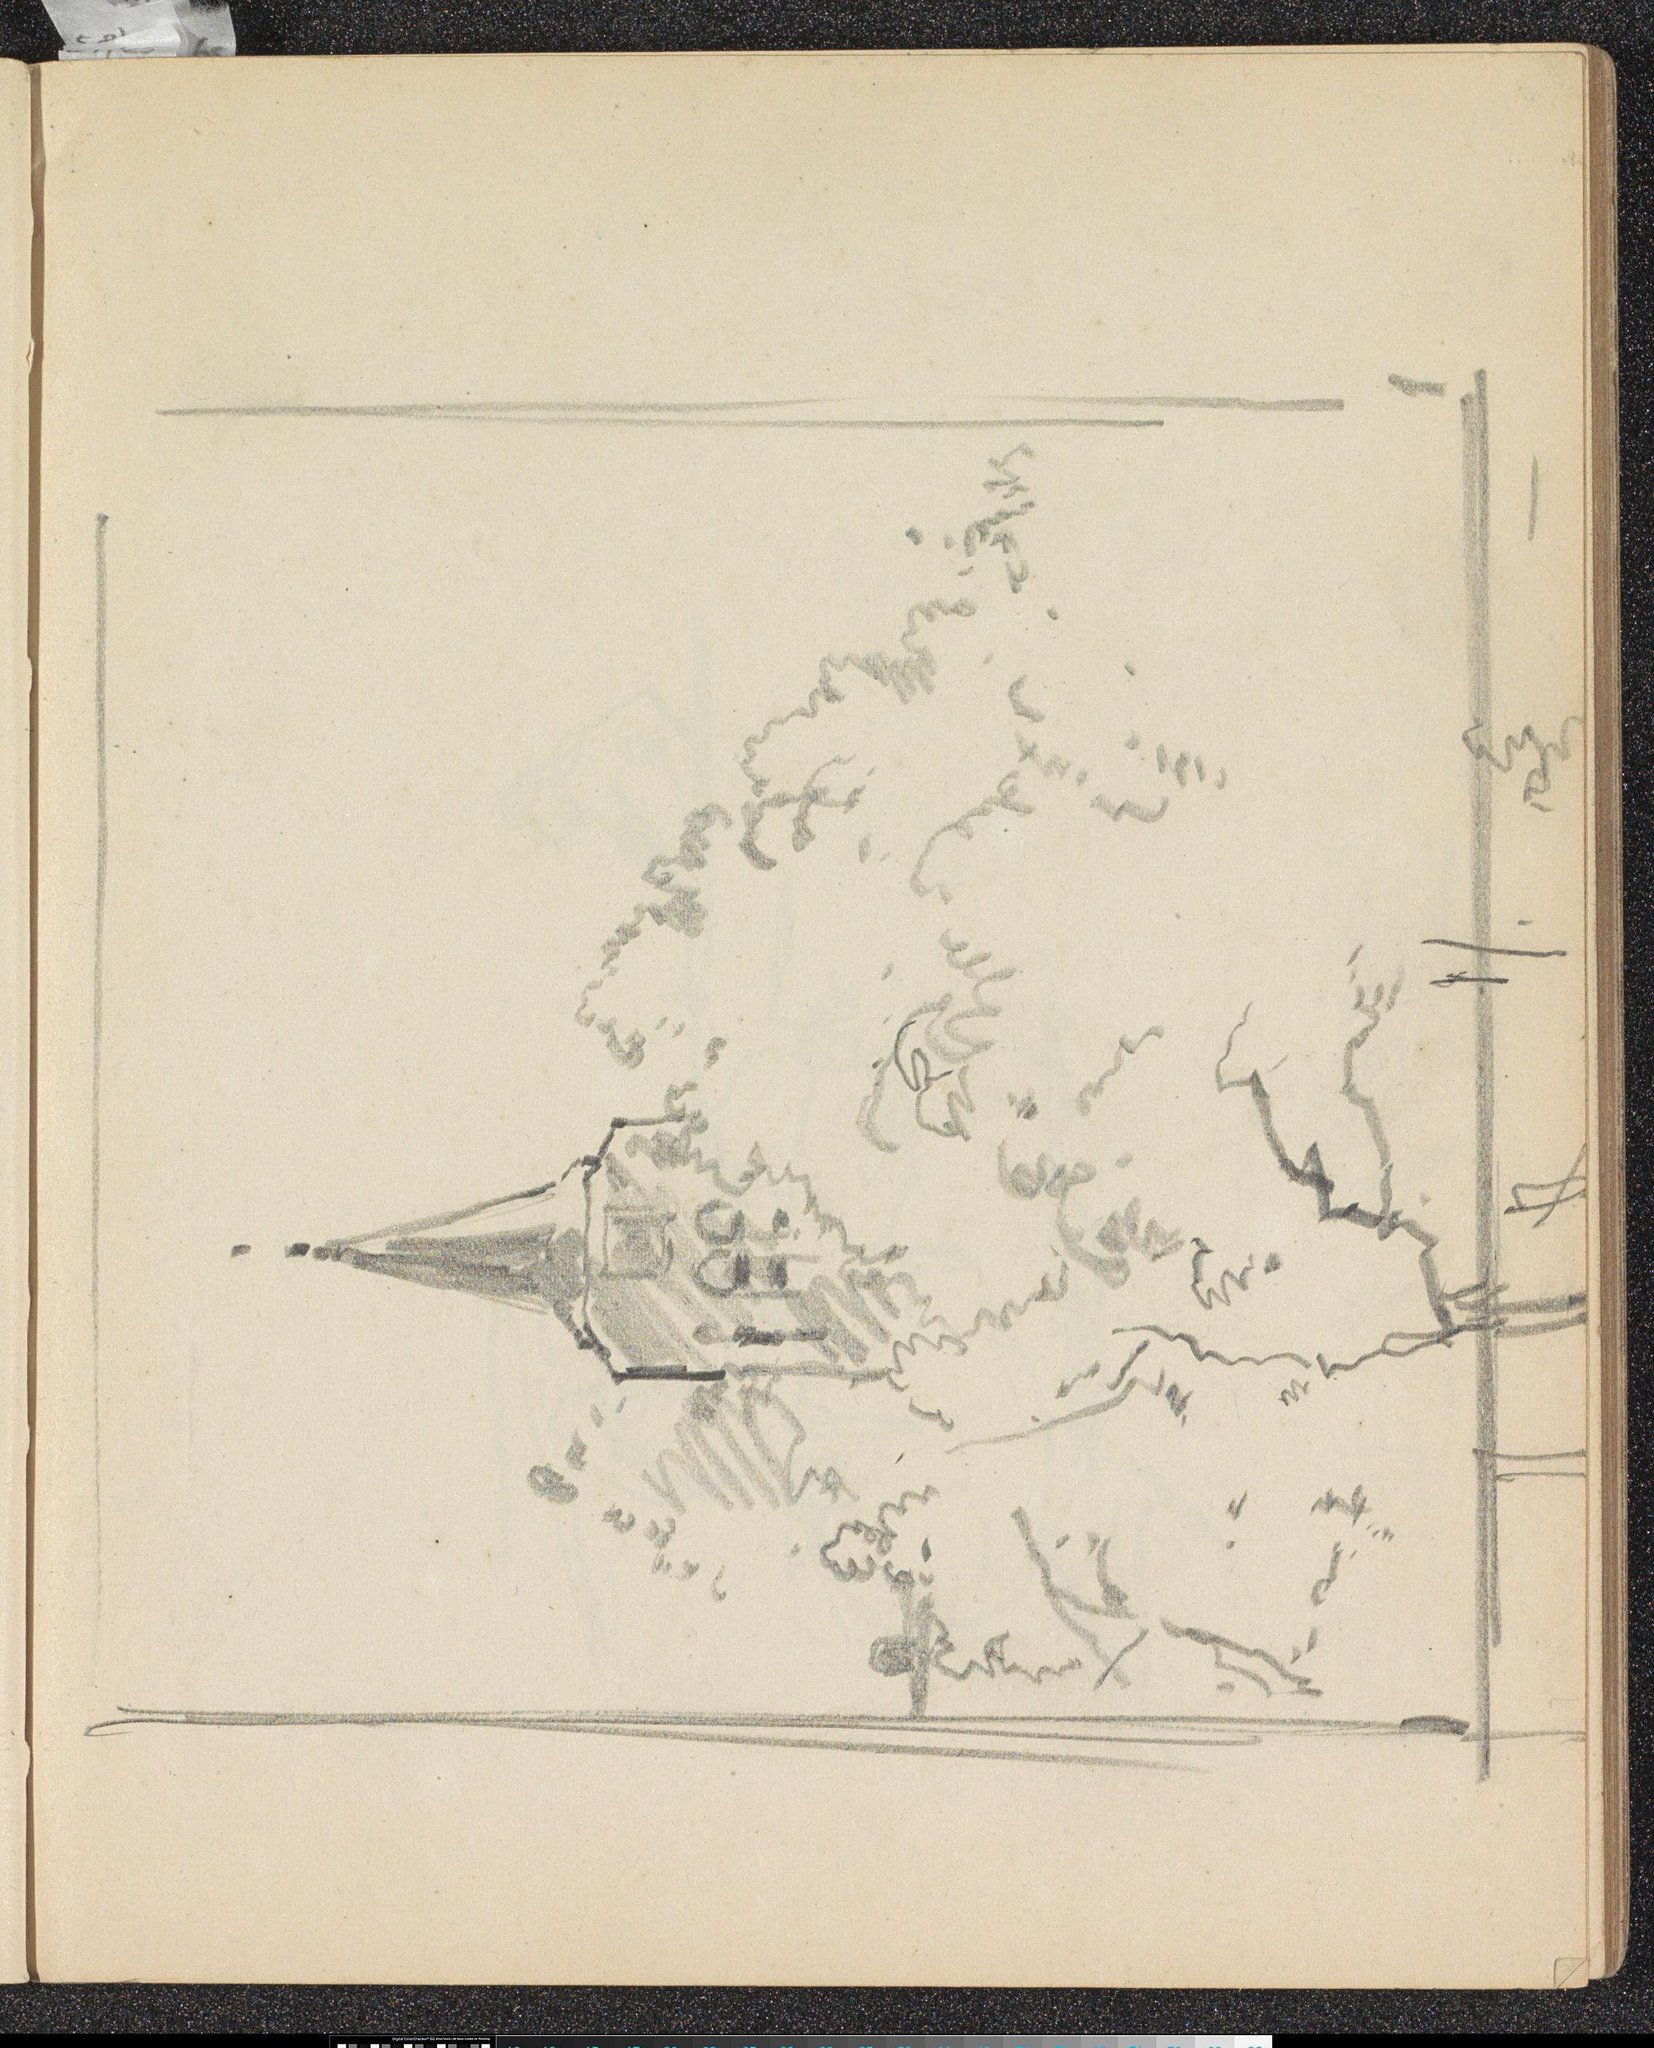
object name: sketchbook leaf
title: Torenspits tussen de bomen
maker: cornelis vreedenburgh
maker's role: draughtsman, print maker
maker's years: 1880-1946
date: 1890-1946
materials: paper, pencil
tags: spire (of tower on house or building)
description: Blad 20 recto uit een schetsboek met 76 bladen.